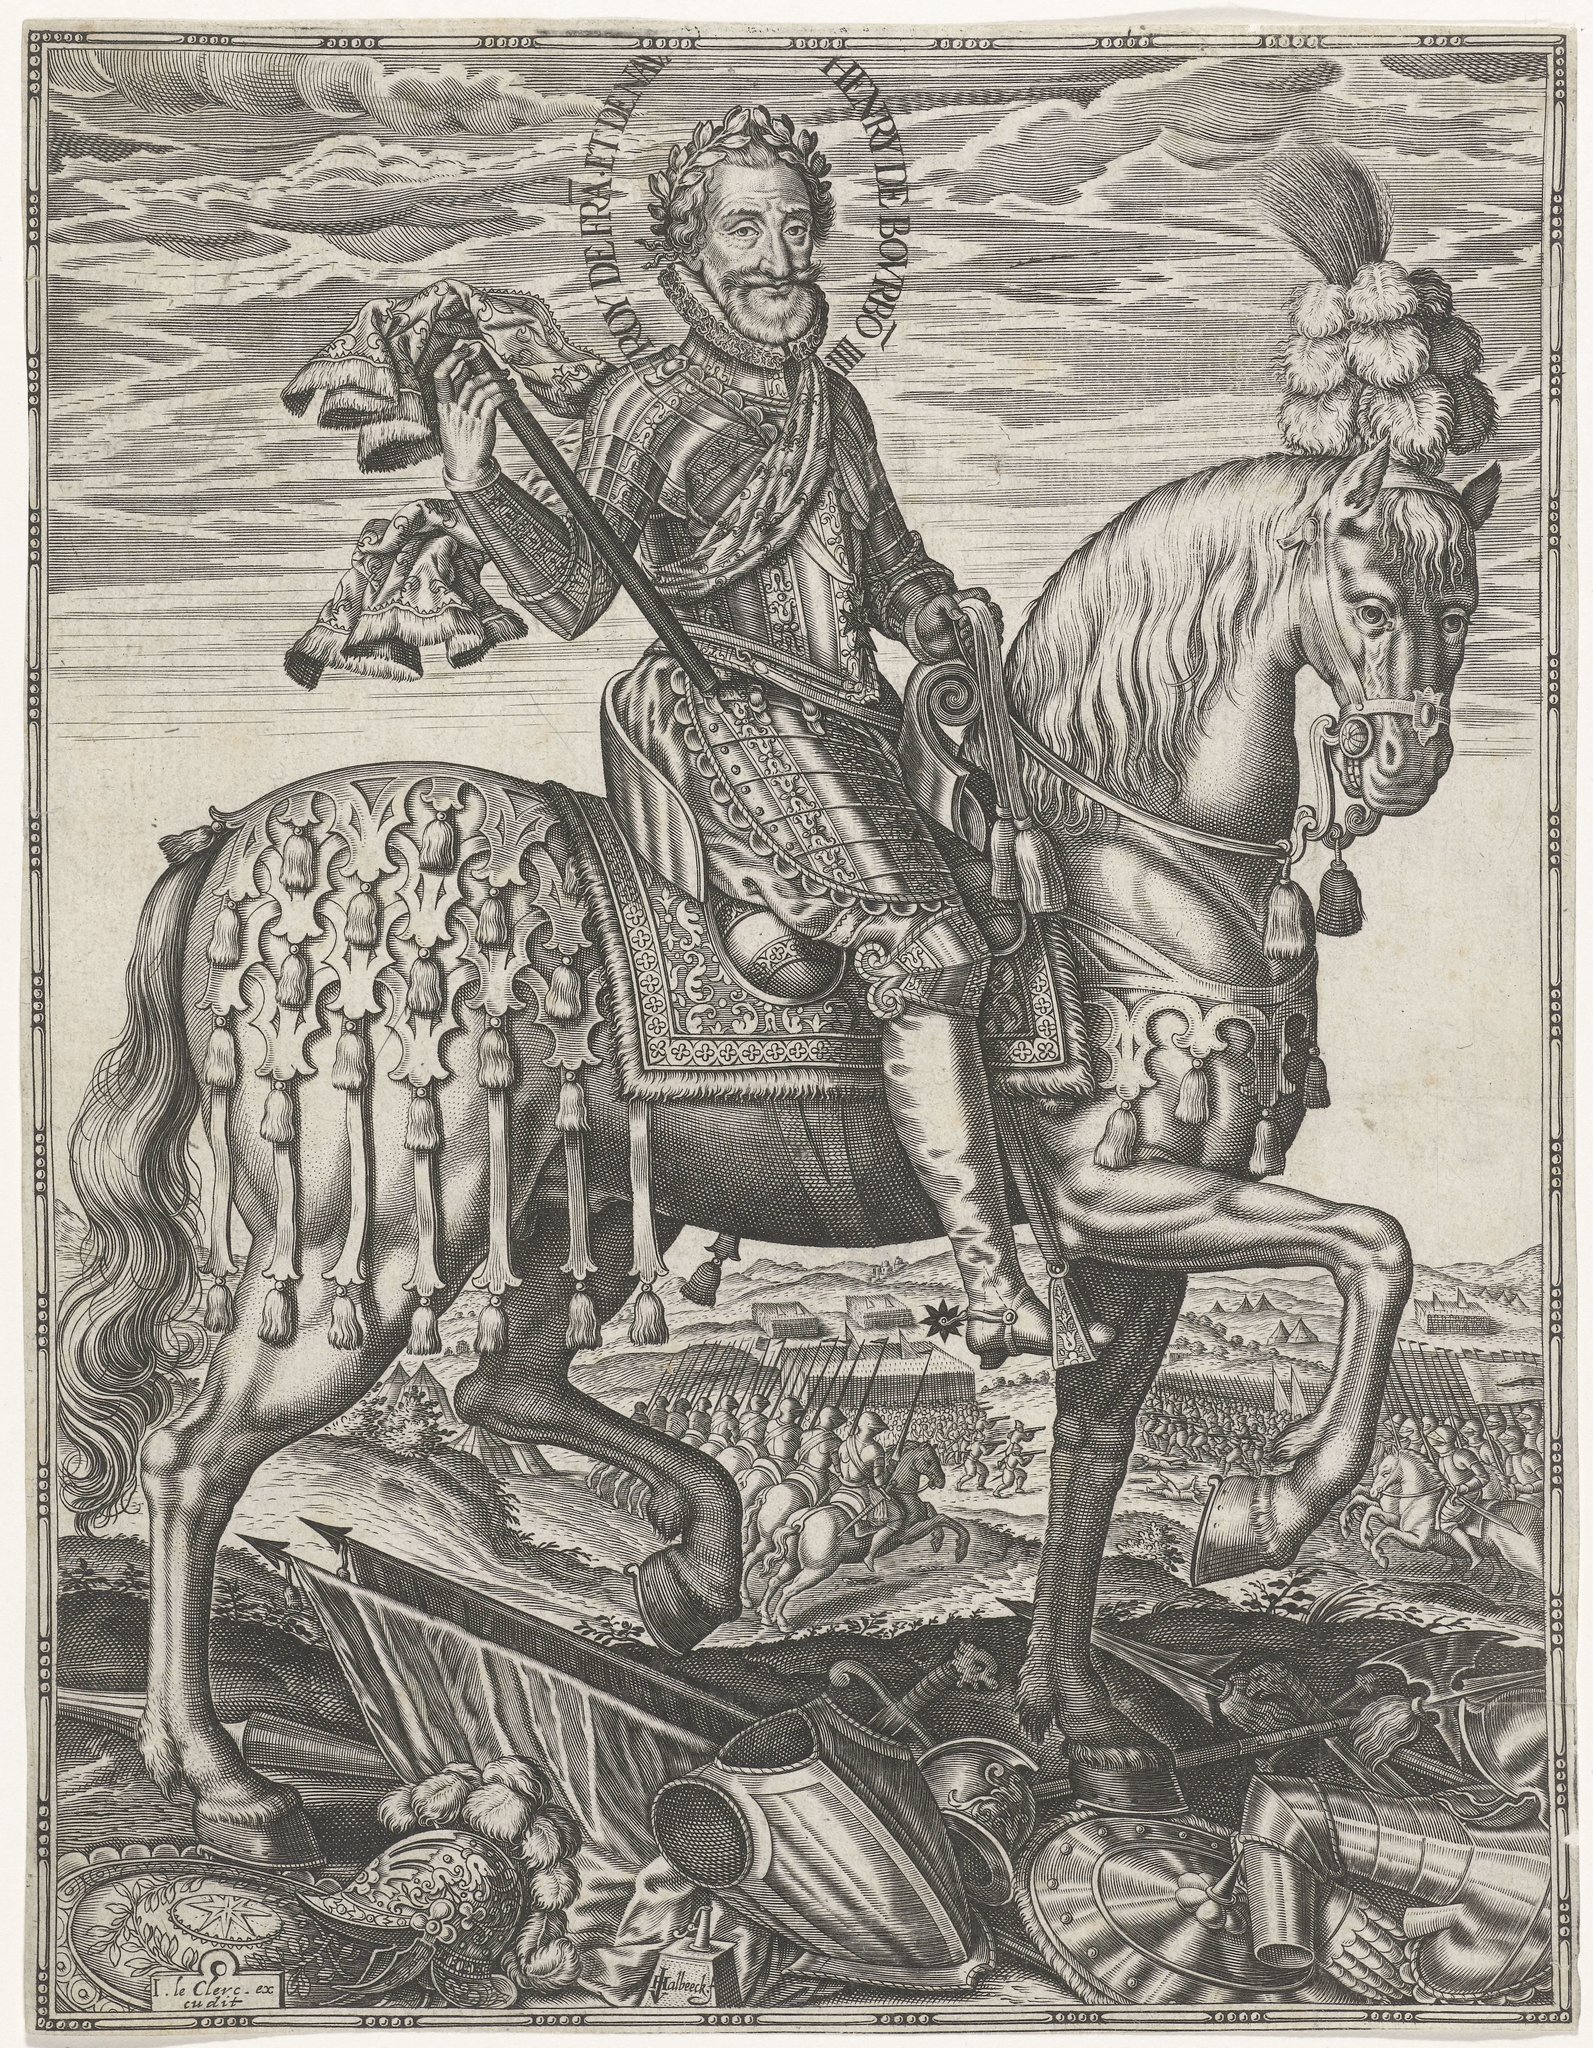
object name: print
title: Portret van Hendrik IV, koning van Frankrijk en Navarre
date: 1600-1610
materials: paper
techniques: engraving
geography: paris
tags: hendrik iv (koning van frankrijk en navarra), riding a horse, ass, or mule; rider, horseman, armour, horse, battle (+ land forces), crowning the victor with laurel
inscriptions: collector's mark: Lugt 2228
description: Ruiterportret van Hendrik IV, koning van Frankrijk en Navarre, gekleed in een harnas. In zijn rechterhand houdt hij een commandostaf en op zijn hoofd draagt hij een lauwerkrans. Rond zijn hoofd in een ovaal zijn naam en titel in het Latijn. Onder het paard liggen oorlogsattributen zoals zwaarden, schilden, harnassen en helmen. Op de achtergrond is een veldslag afgebeeld.